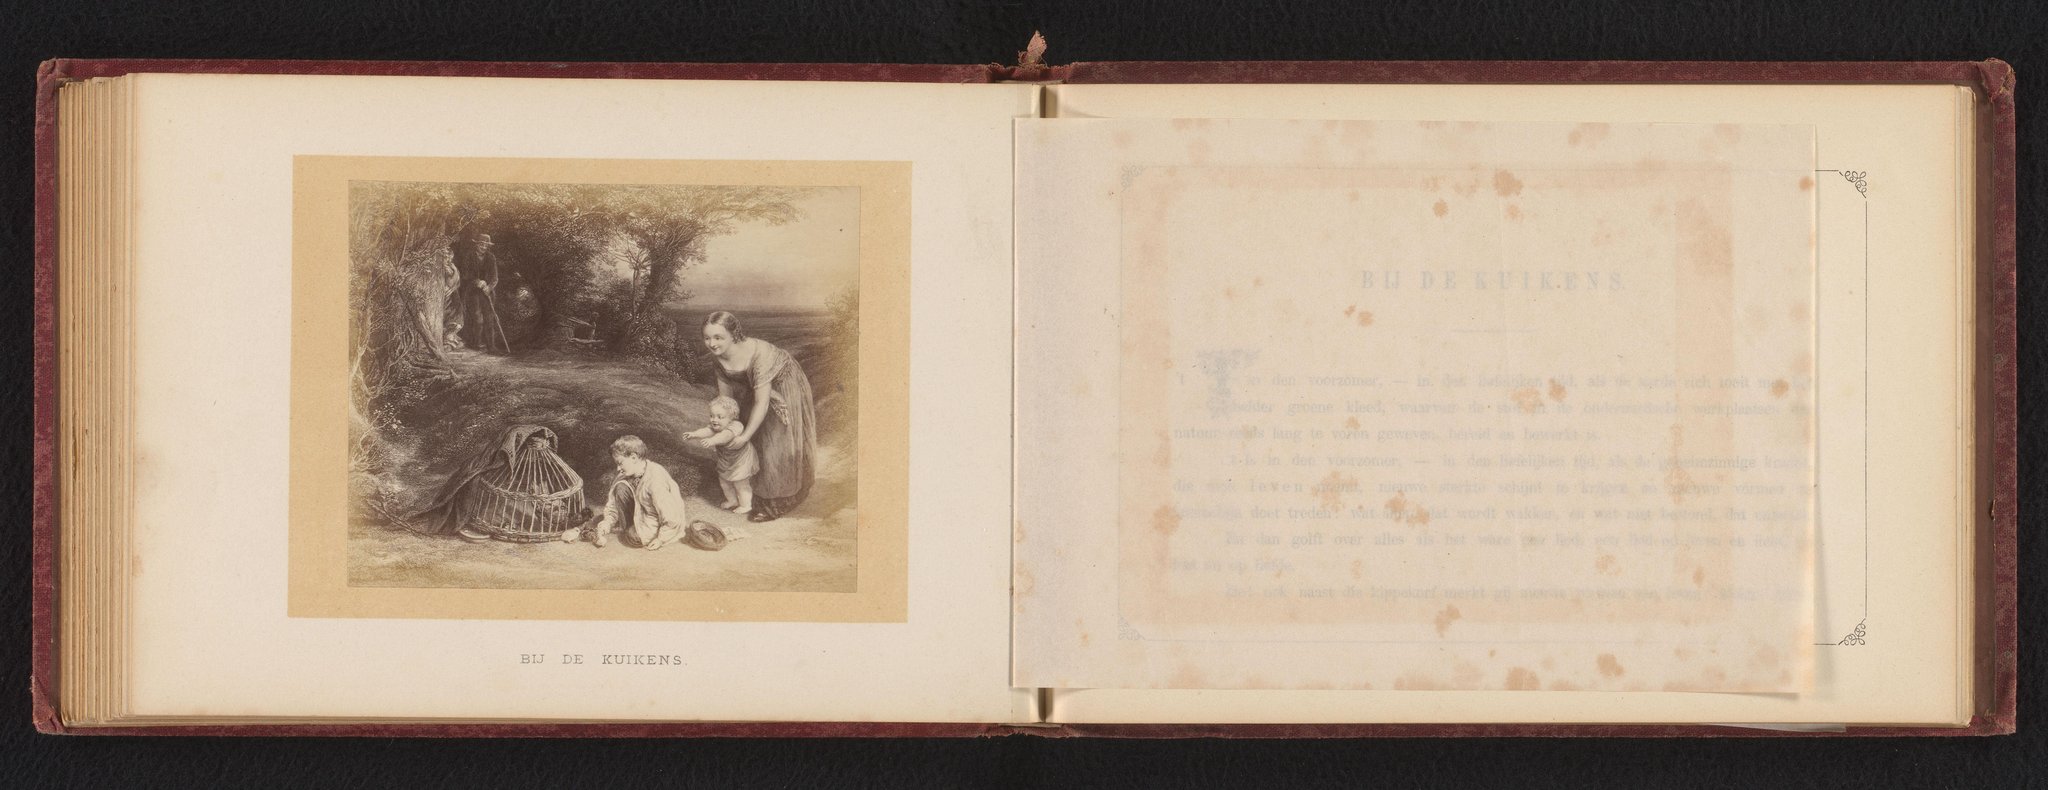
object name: page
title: Fotoreproductie van de gravure Bij de kuikens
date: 1872-1875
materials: paper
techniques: albumen print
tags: print, e.g.: engraving, etching, lithograph, family life, chicken house